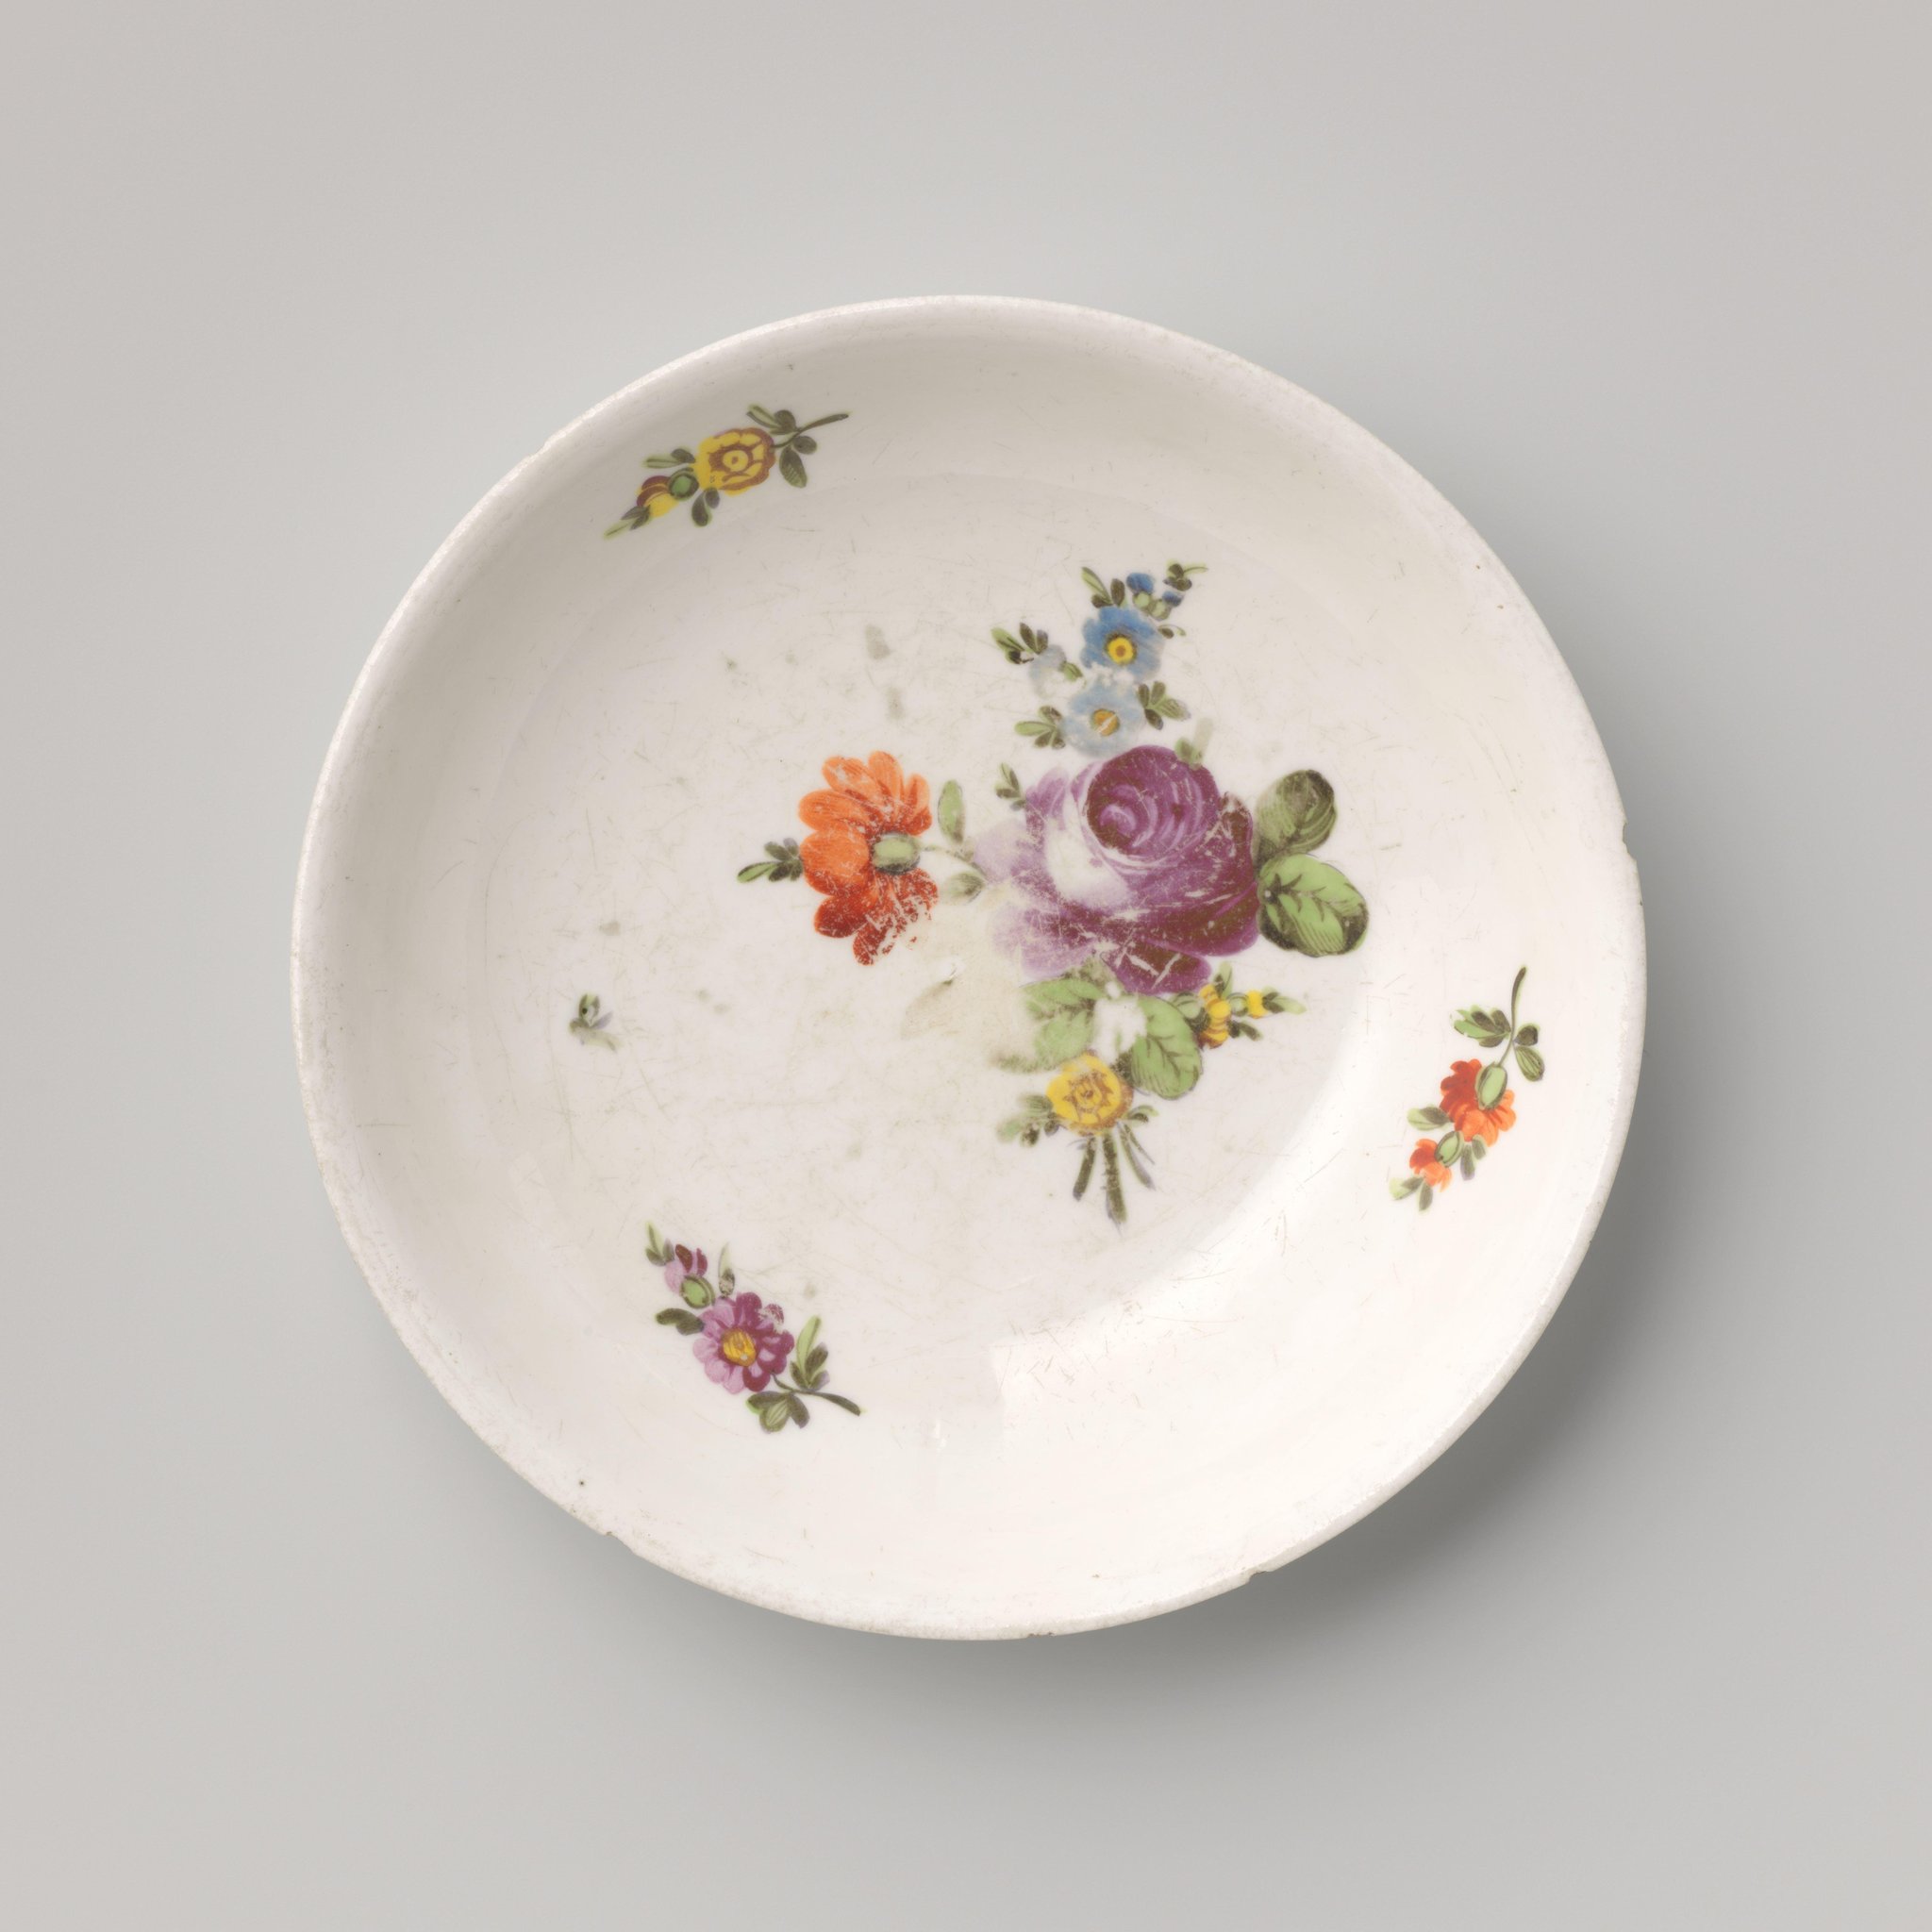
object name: service set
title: Saucer with a bouquet and flower sprays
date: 1800-1849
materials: glaze, paint, porcelain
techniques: firing, forming, turning, vitrification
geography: vienna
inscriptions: mark: ‘schild/ A/ F/ 33/ 24/ I’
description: Schotel van porselein met een gelobde rand, beschilderd op het glazuur in blauw, rood, roze, groen en geel. Op het plat een boeket van verschillende bloemen (o.a. pioenroos) omgeven door bloemtakken. Gemerkt op de onderzijde met het schild, de letters A en F en de nummers 33, 24 en I.